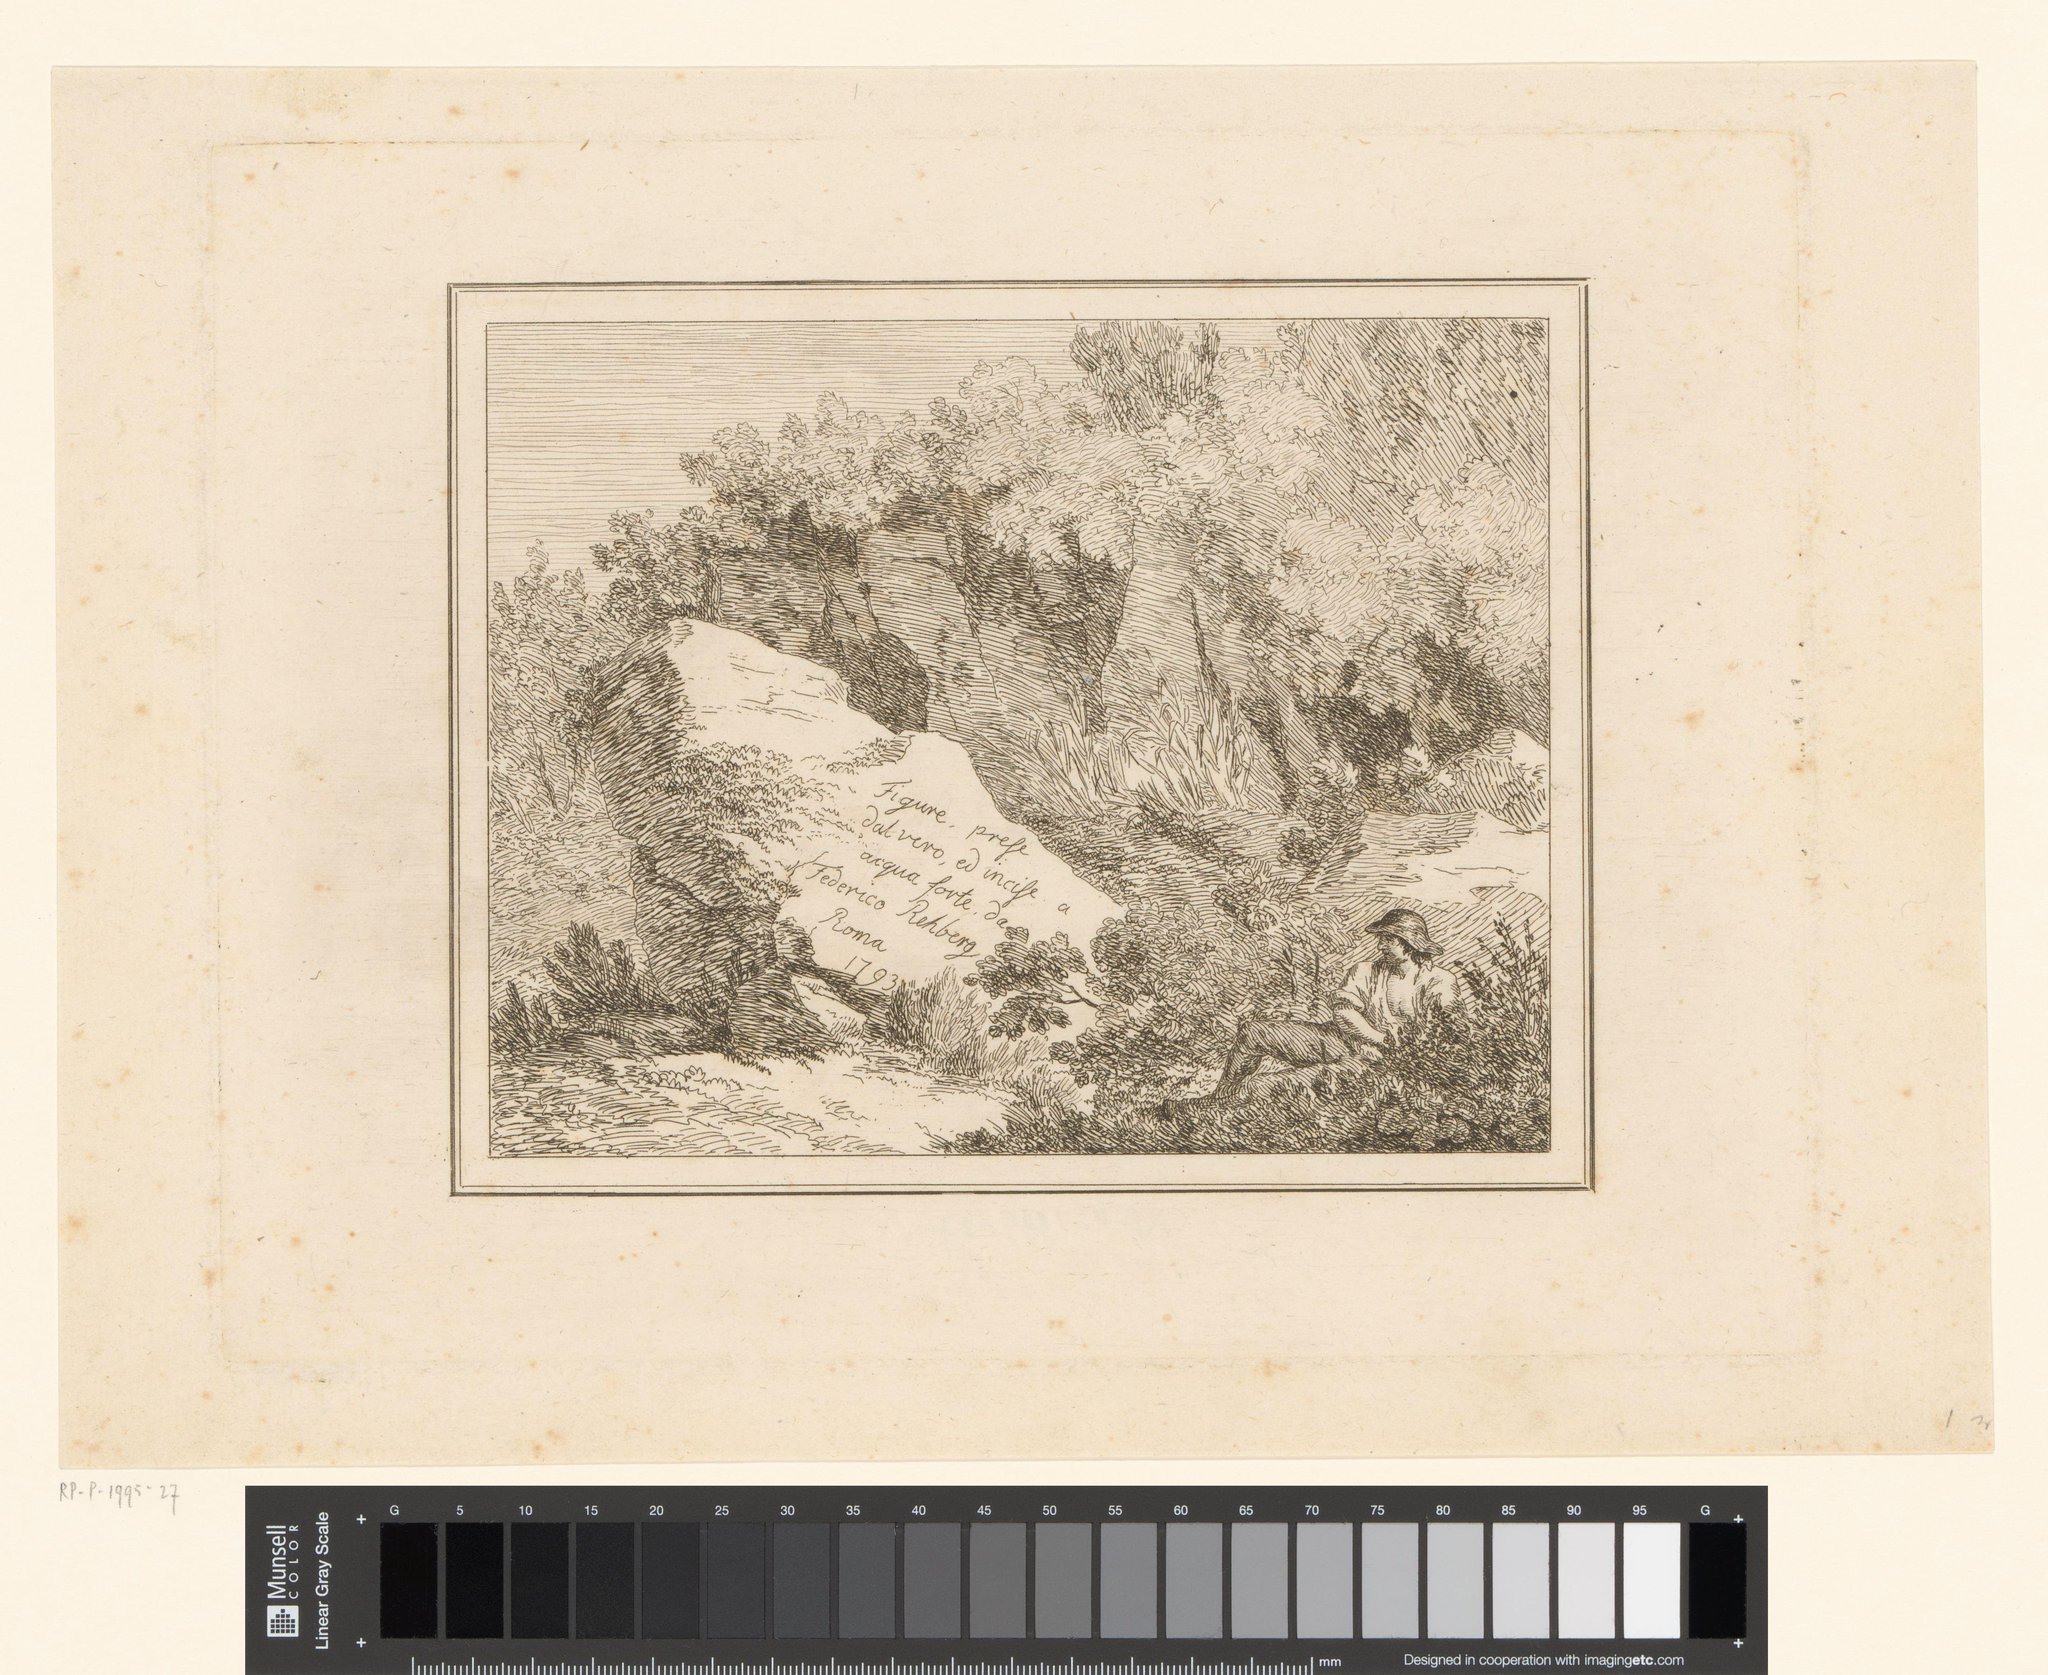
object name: print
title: Scènes uit het dagelijks leven in Italië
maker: friedrich rehberg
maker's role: print maker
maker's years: 1785-1835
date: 1793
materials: paper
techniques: etching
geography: rome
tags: landscapes, (traveller) resting in the open air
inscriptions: collector's mark: Lugt 2760, collector's mark: Lugt 2228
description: Titelprent voor de serie "Figure prese dal vero", 6 bladen.